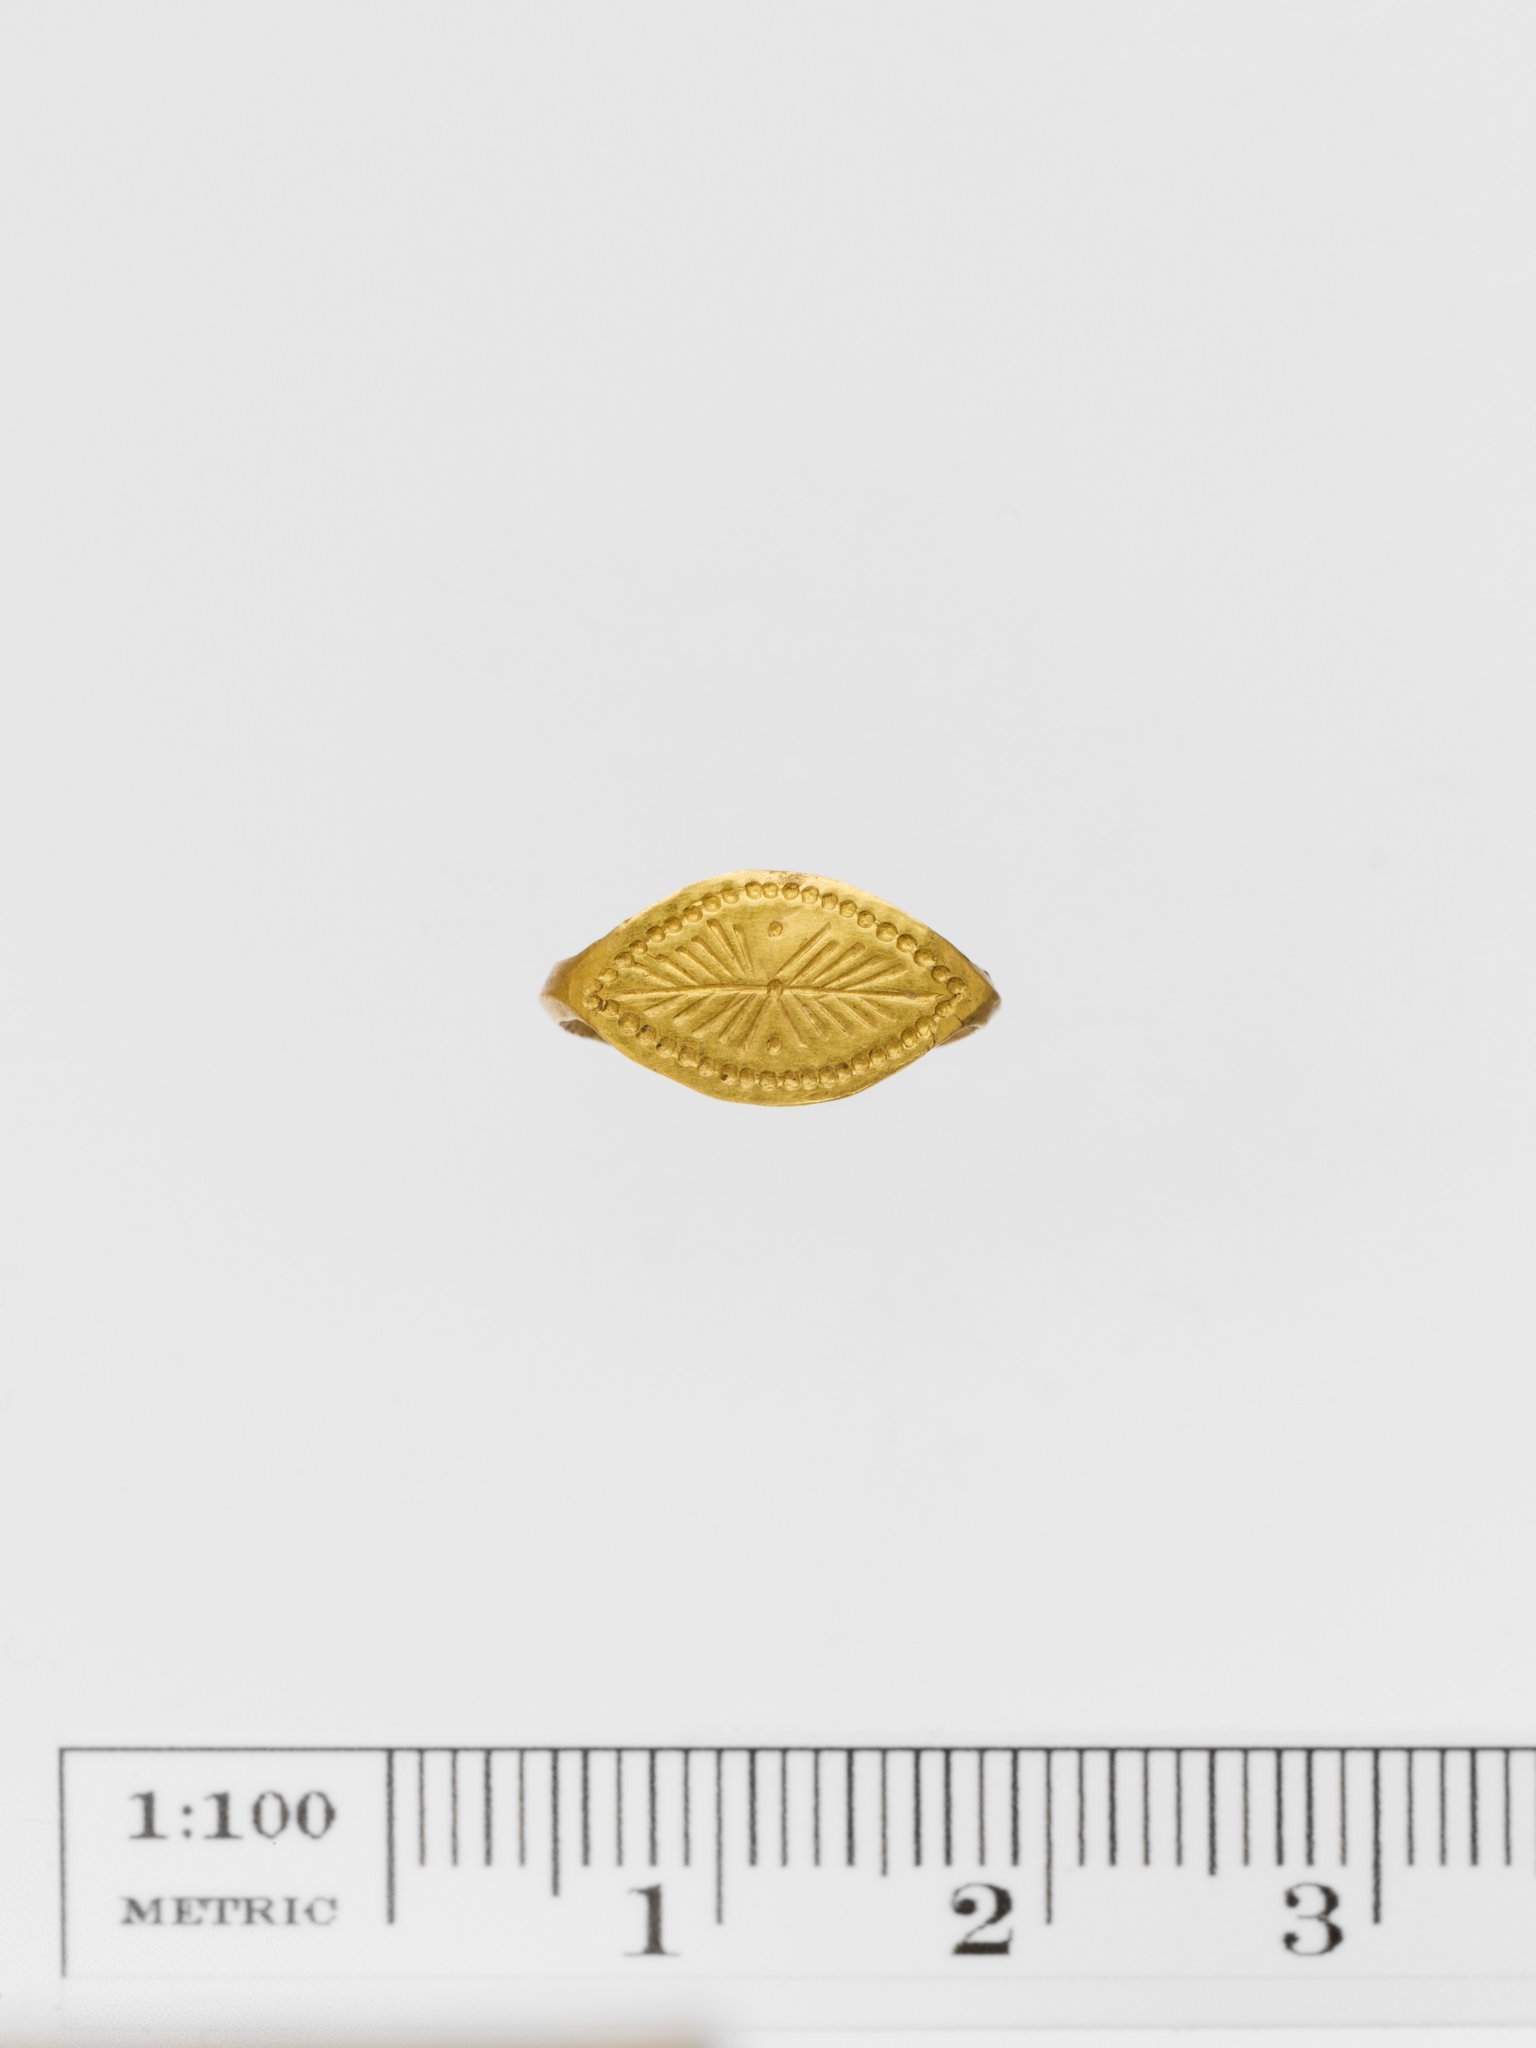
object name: ring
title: Gold ring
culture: greek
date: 400-301 BCE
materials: gold